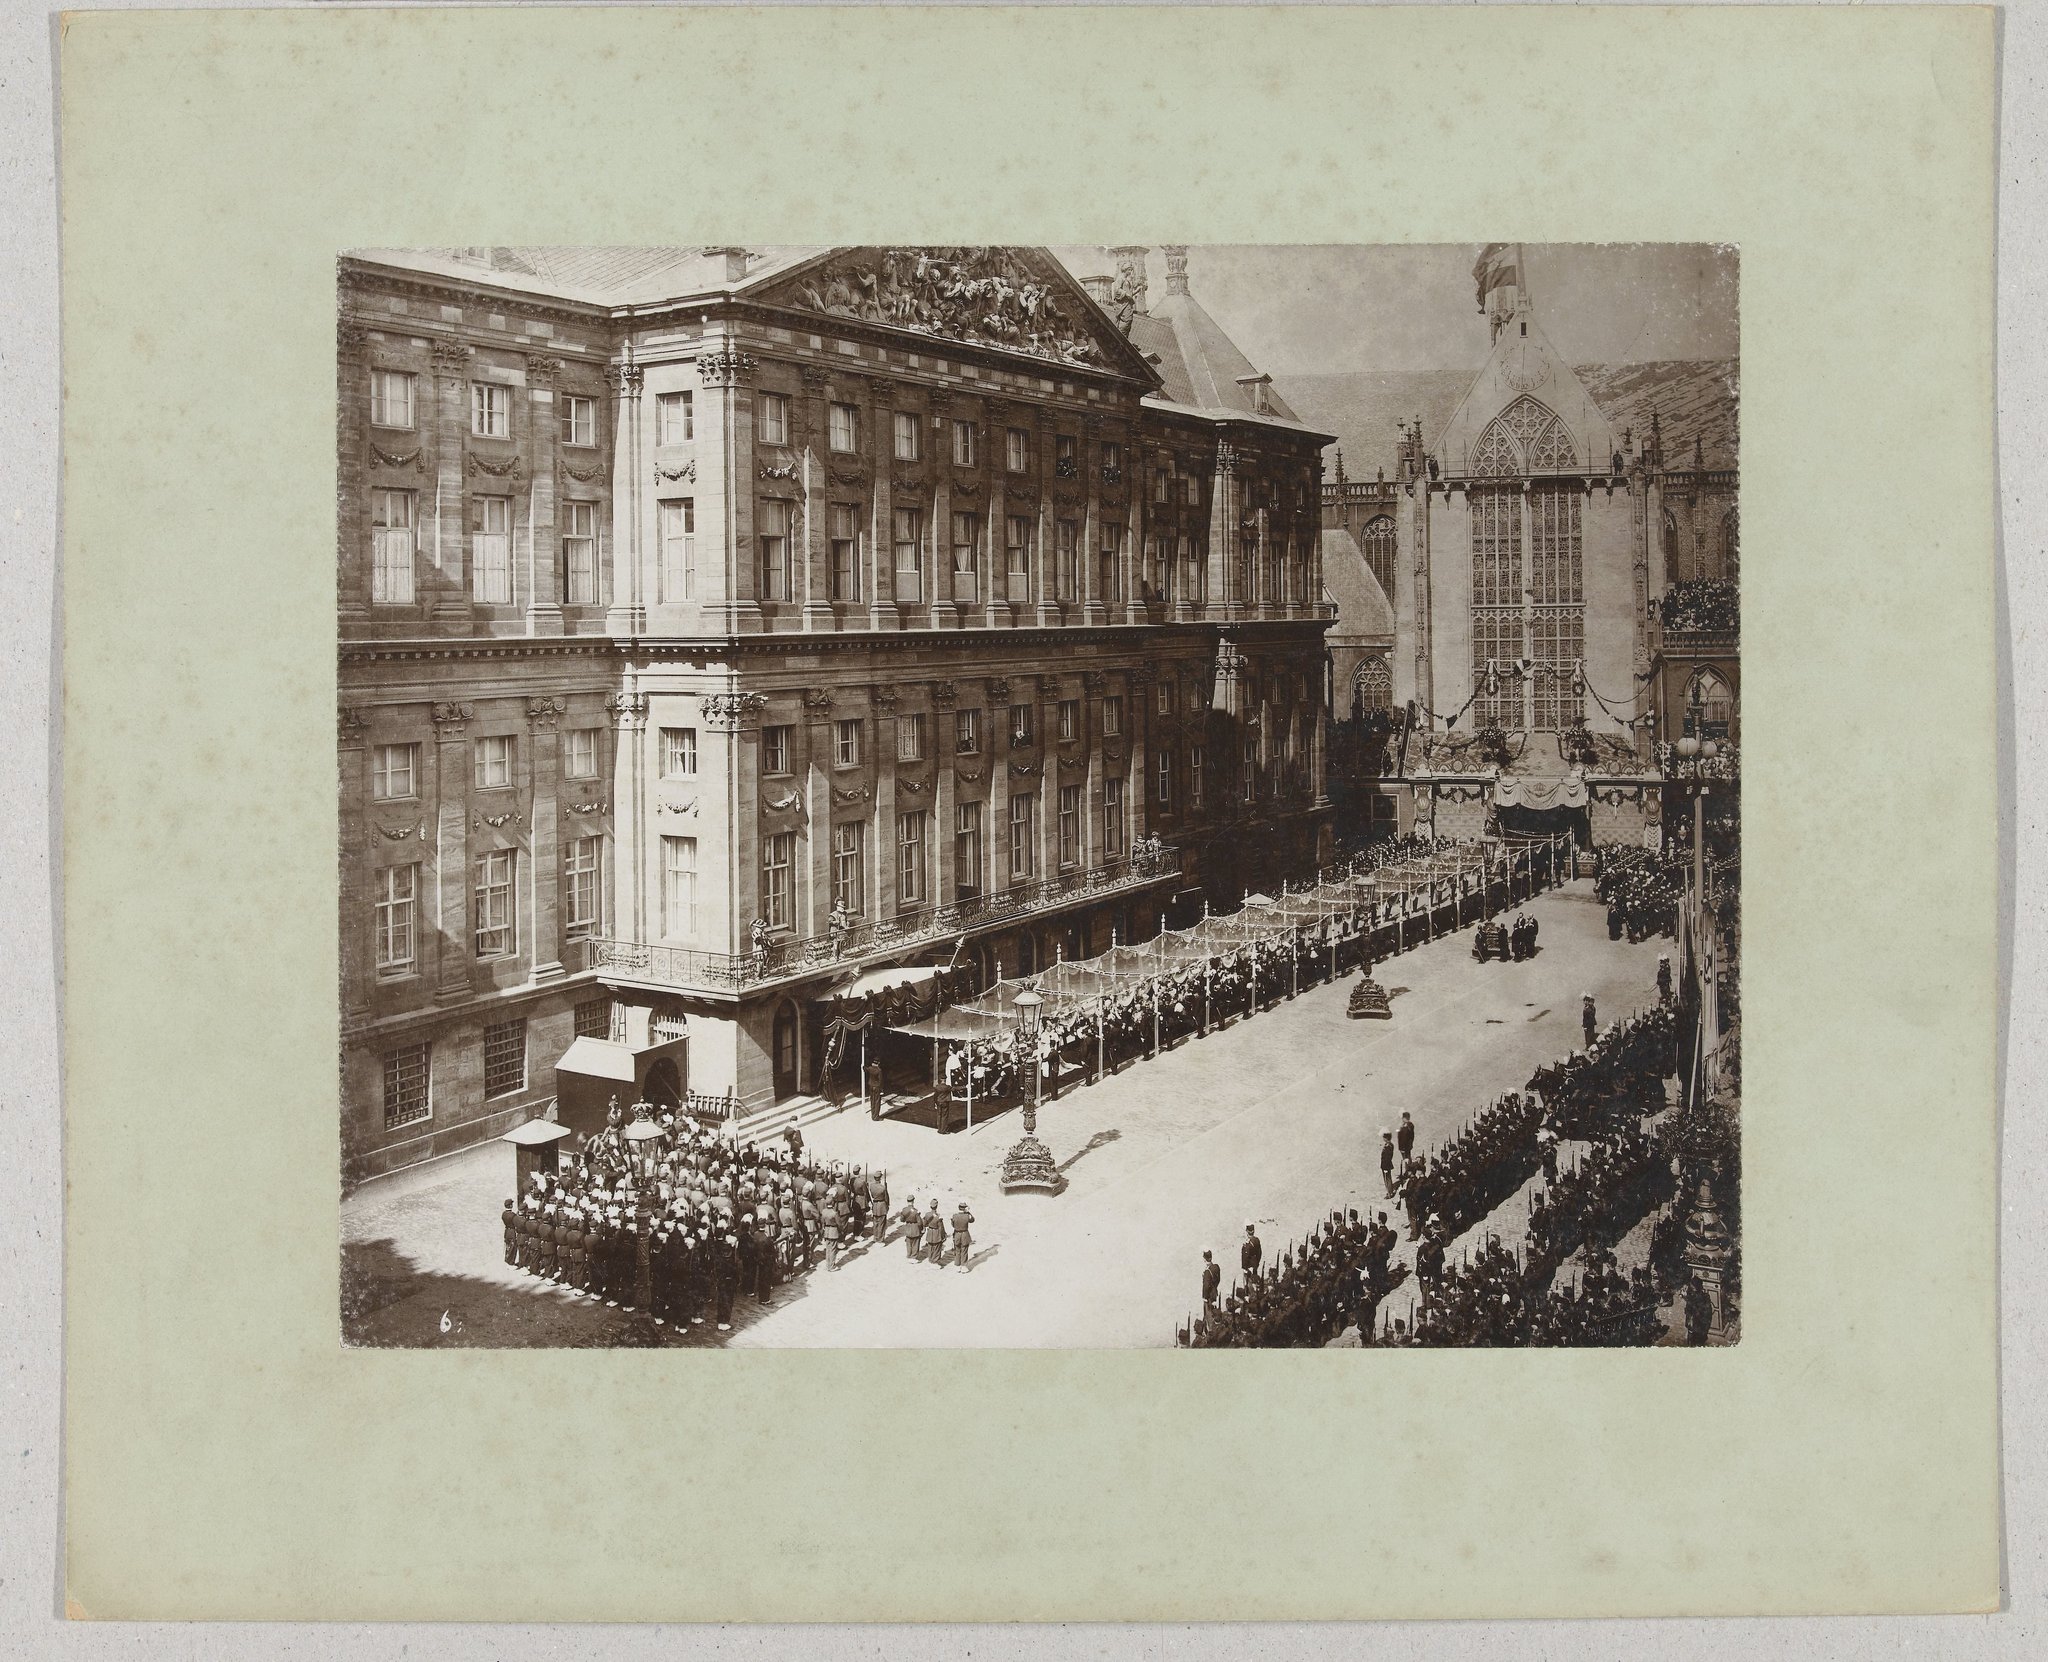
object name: photograph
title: No 6, 6 september 1898. Terugkeer uit de N. Kerk na de plechtige Inhuldiging van H. M. Koningin Wilhelmina te Amsterdam. uitgave Herz Amsterdam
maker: sigmund löw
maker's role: publisher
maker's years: 1845-1920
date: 1898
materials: paper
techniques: collodion silver print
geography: amsterdam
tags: the hague, print maker, wilhelmina of the netherlands, after the coronation, palace, royal palace of amsterdam, amsterdam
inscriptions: name: ‘Atelier Herz Amsterdam’